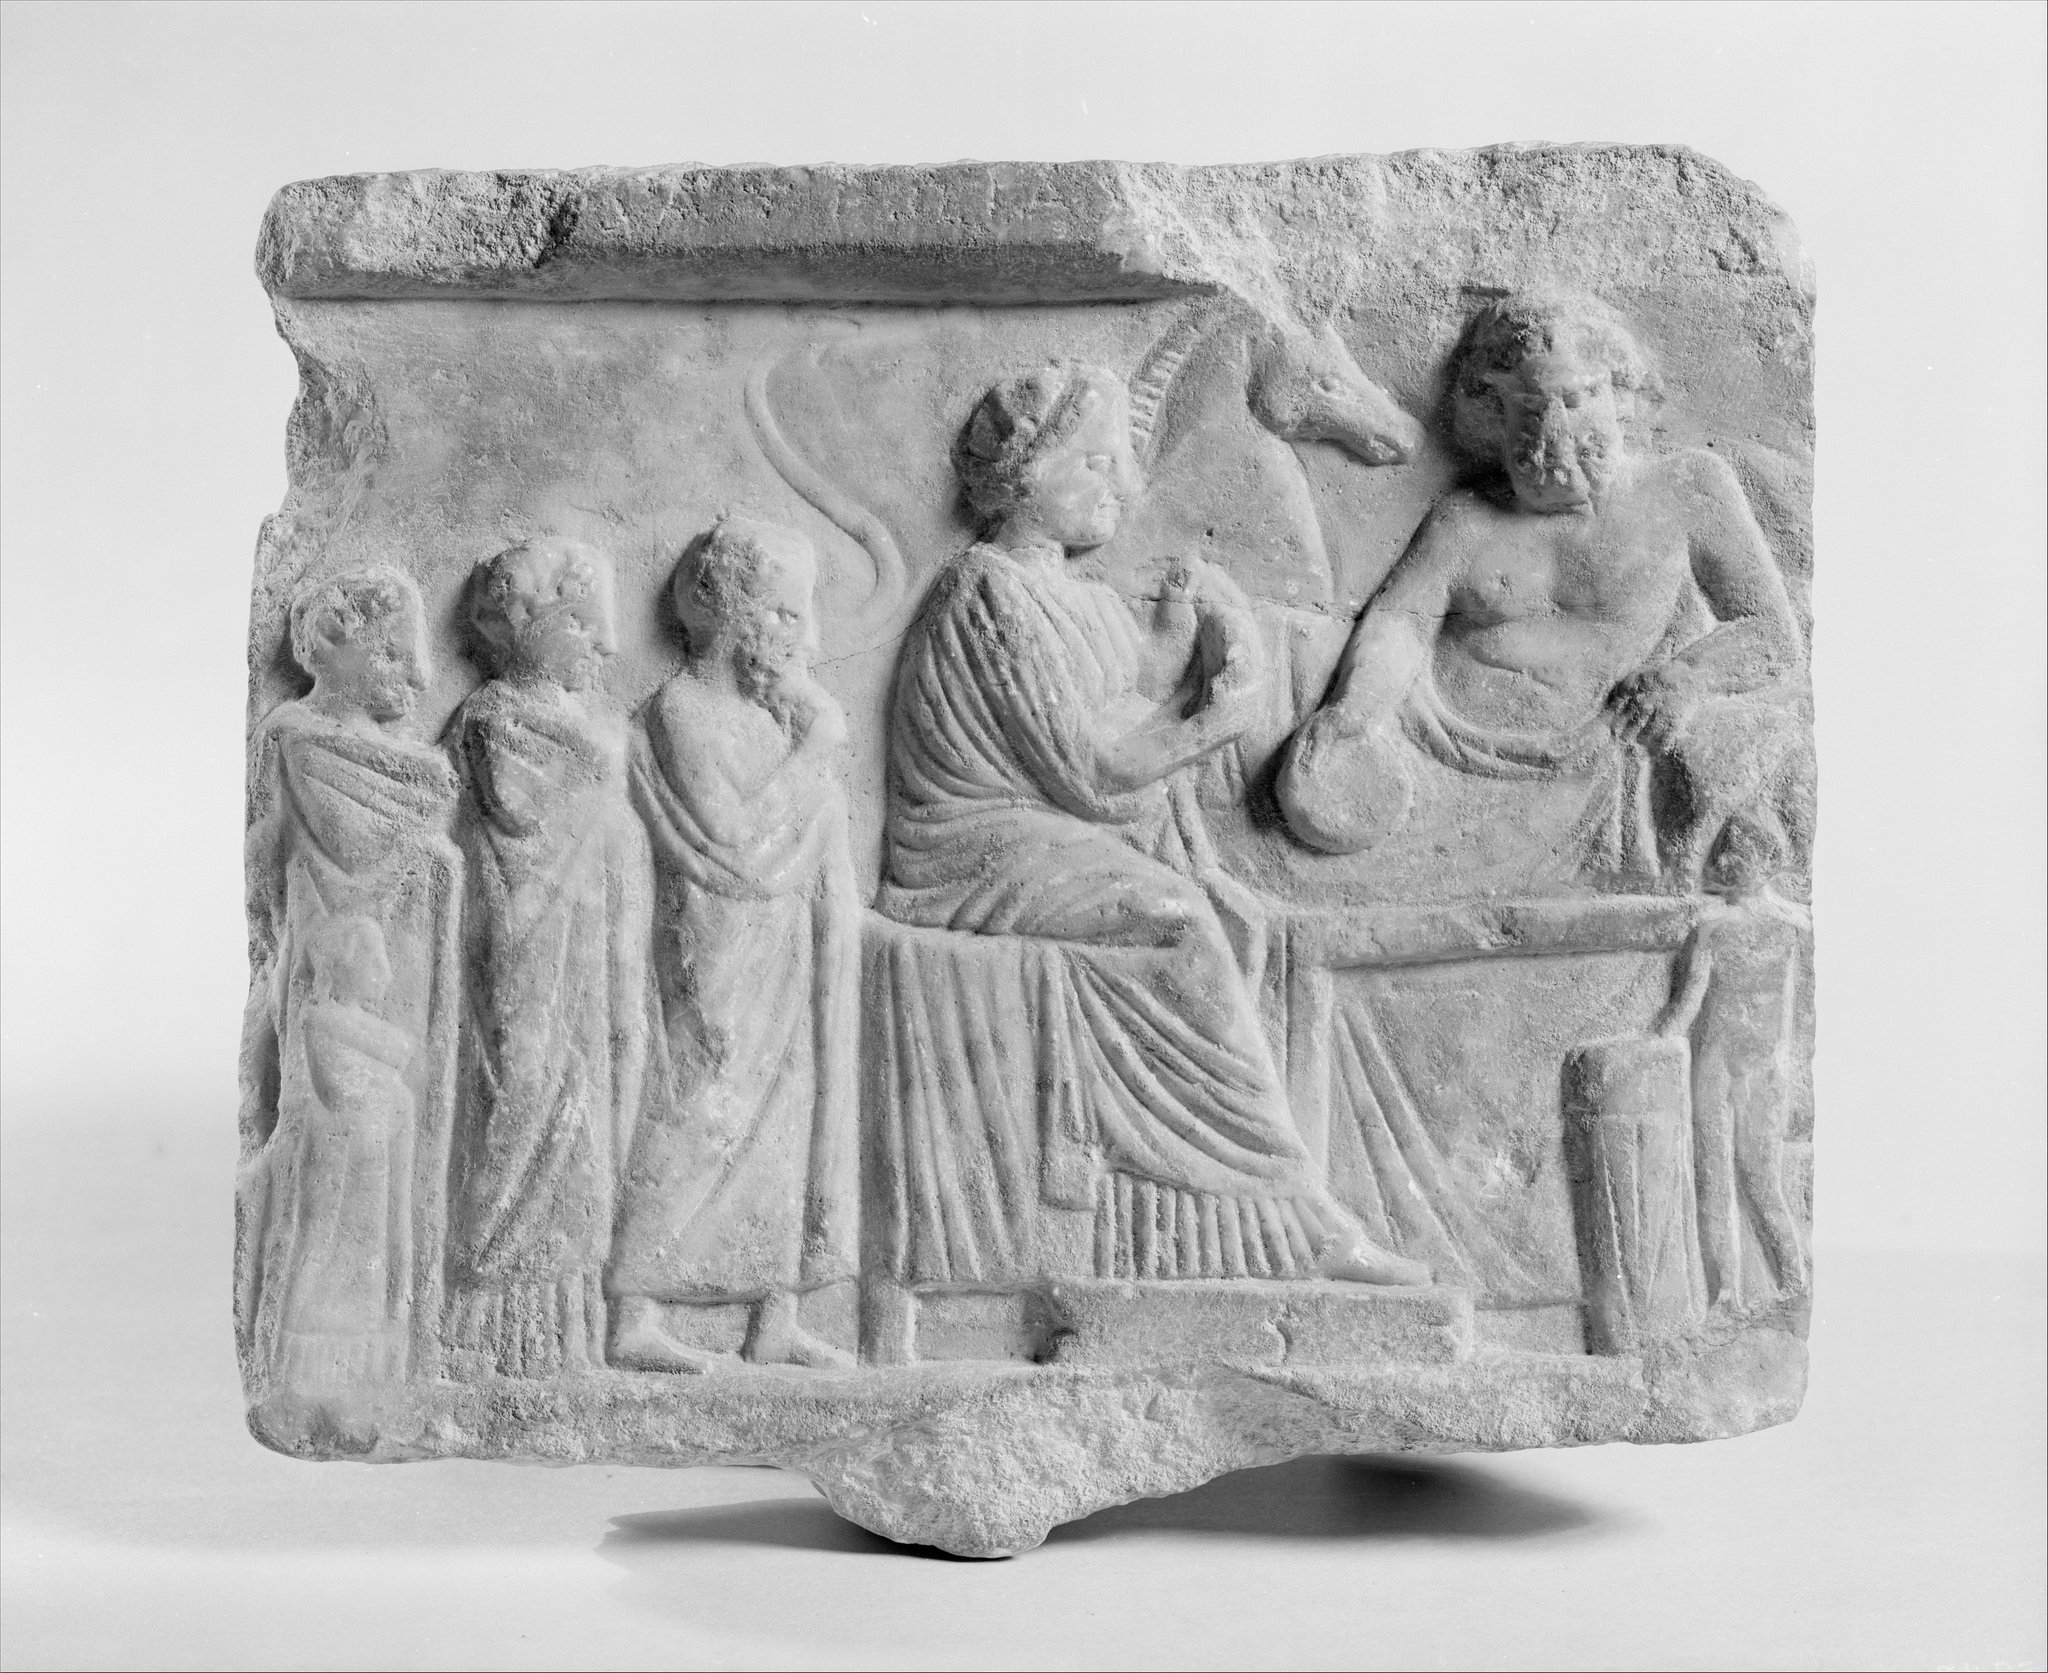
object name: votive relief, fragment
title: Marble votive relief dedicated to a hero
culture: greek, attic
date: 334-301 BCE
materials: marble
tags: men,women,horses